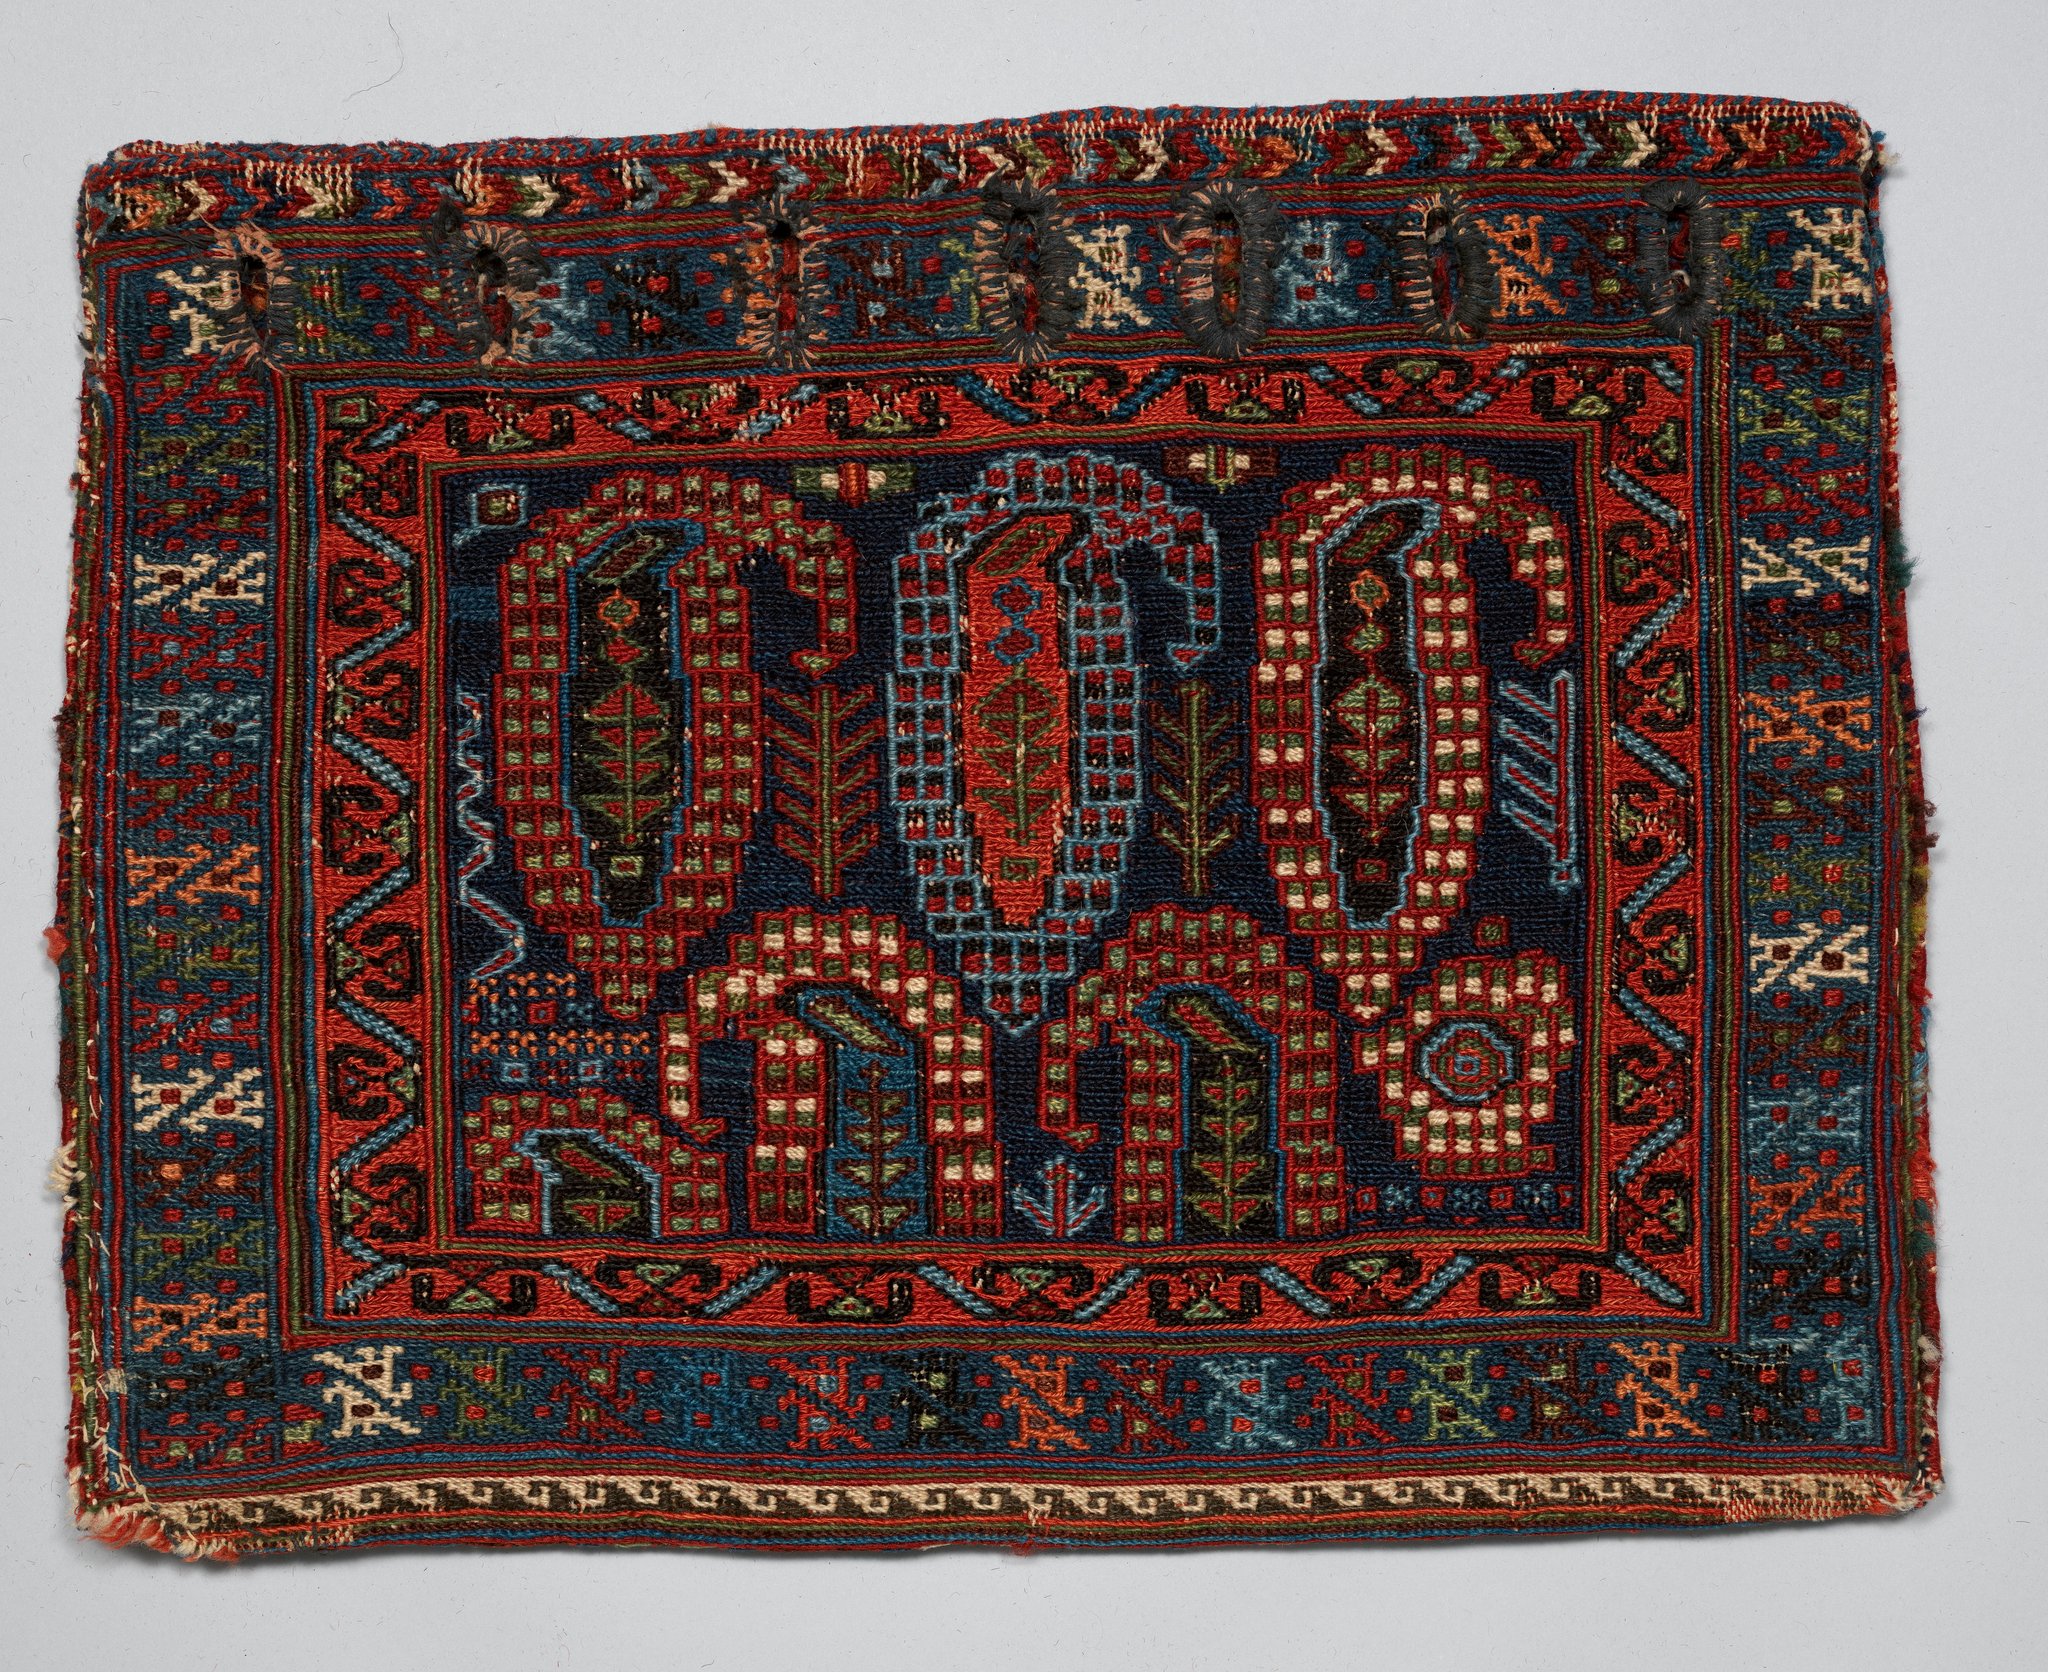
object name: bag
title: Small Torba Bag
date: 1900-1910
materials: wool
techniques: asymmetrically knotted pile, brocade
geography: iran